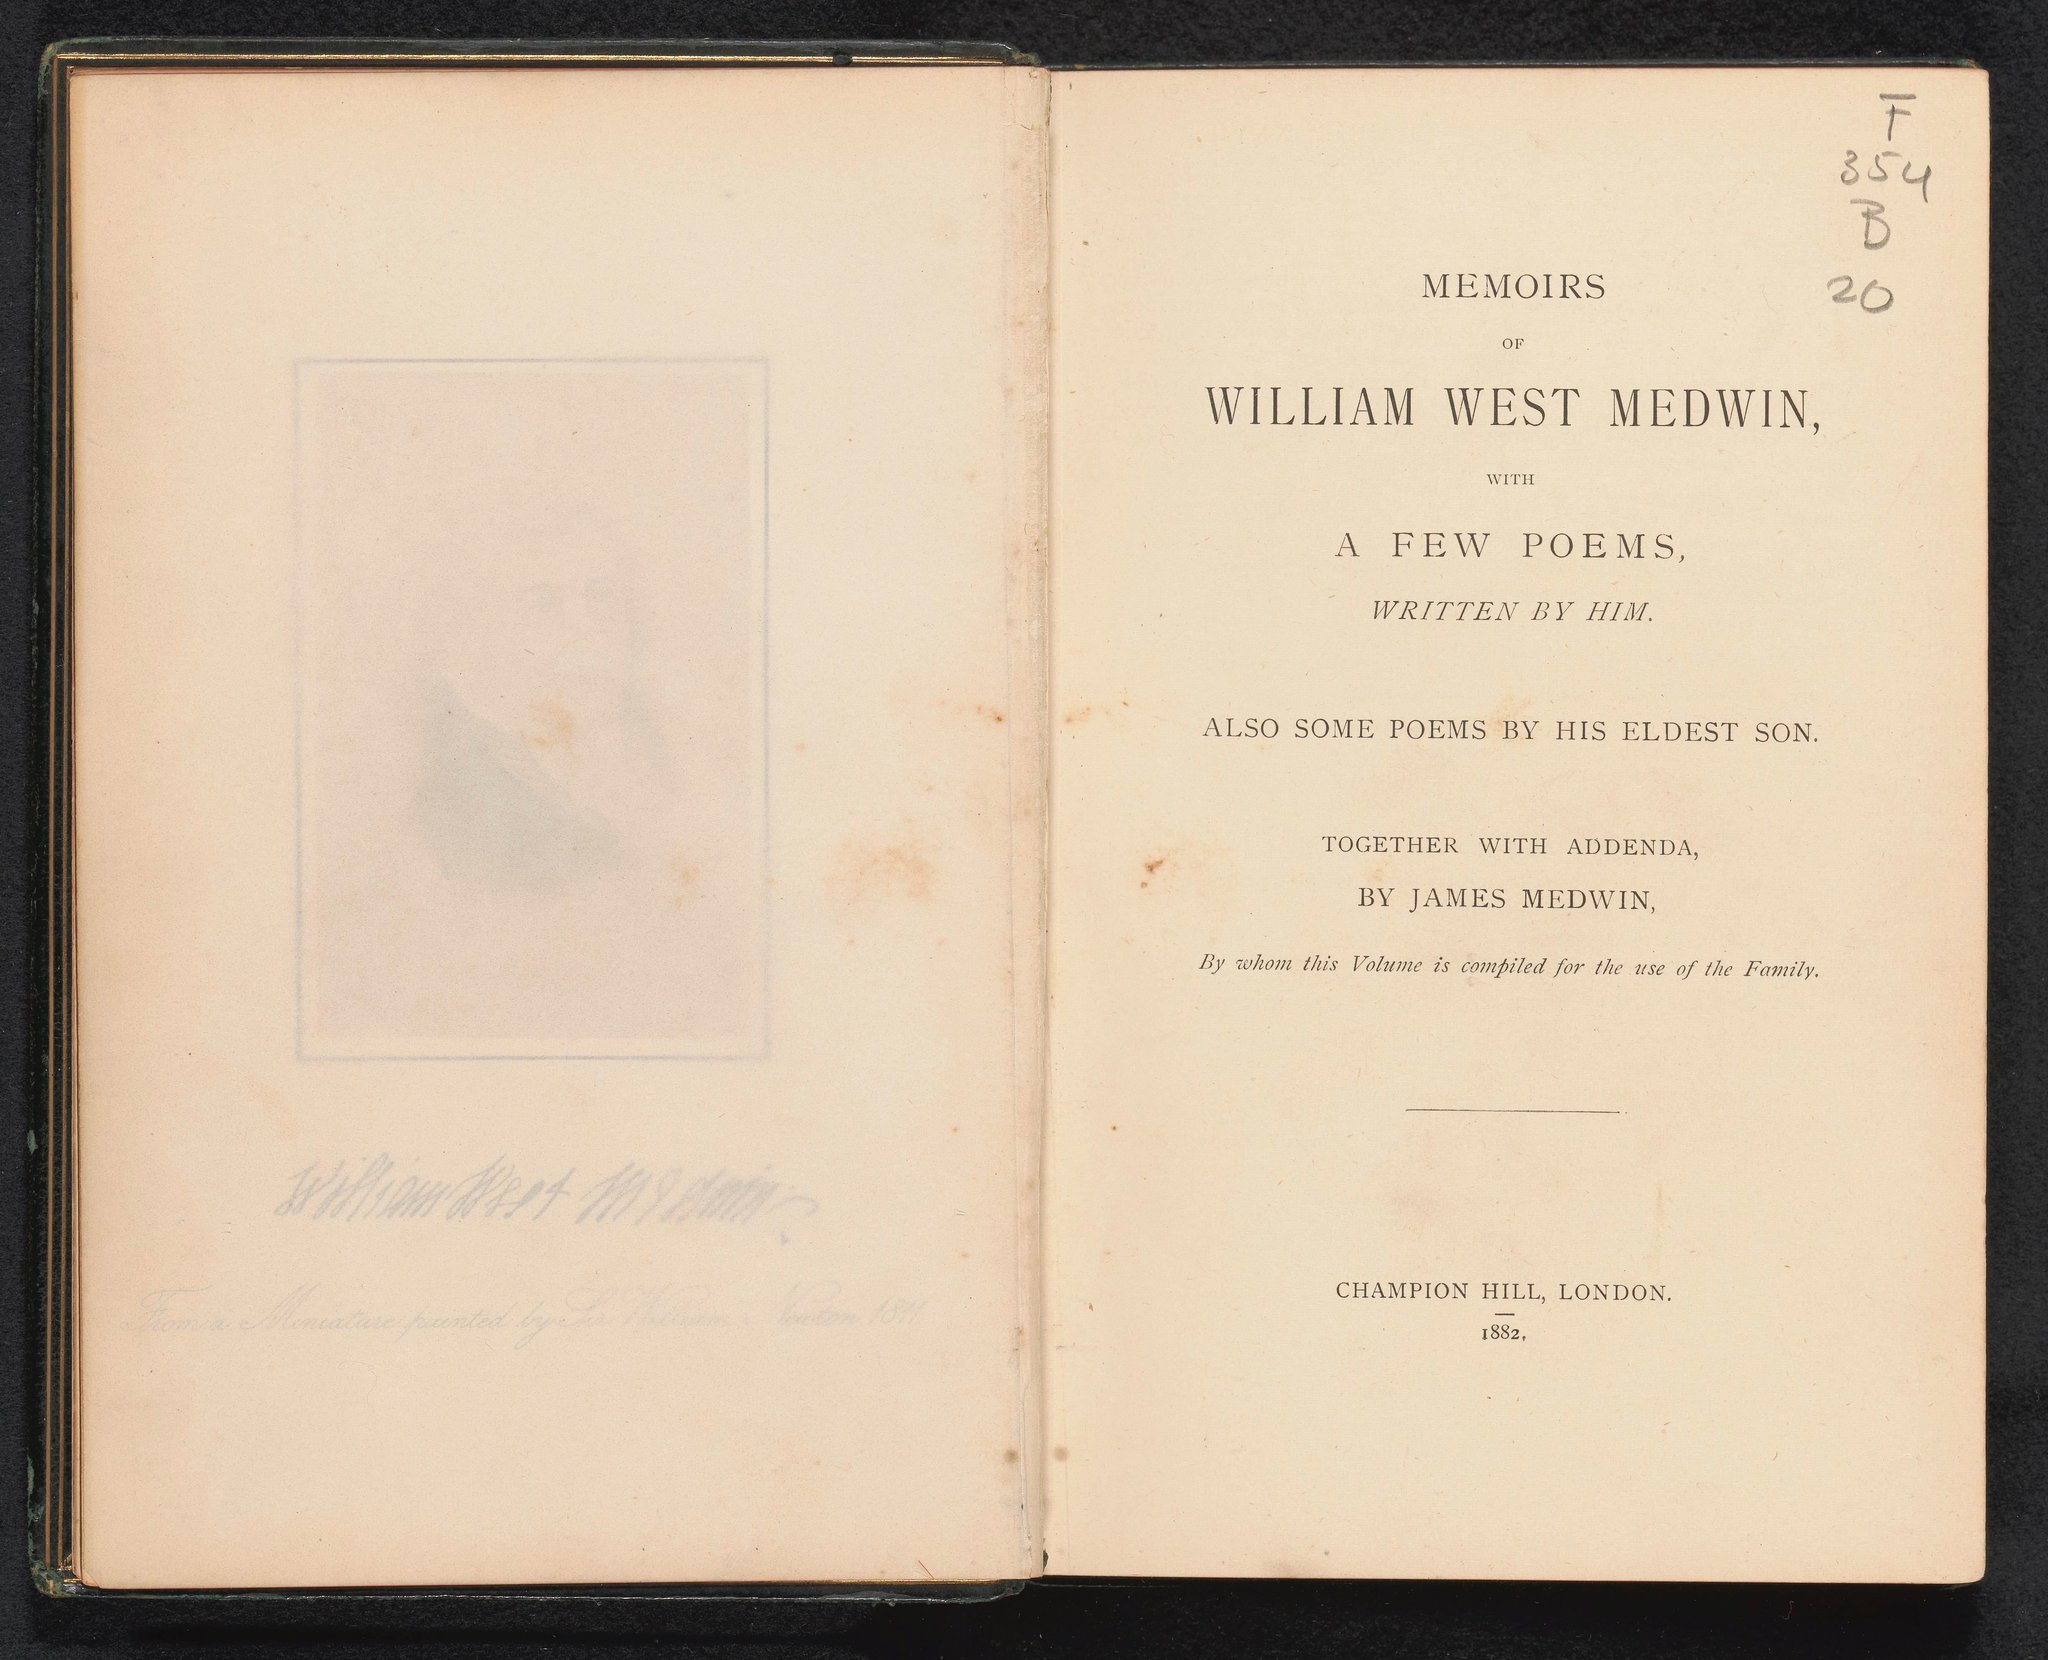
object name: book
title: Memoirs of William West Medwin, with a few poems written by him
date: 1882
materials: cardboard, leather, paper, photographic support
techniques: albumen print, printing, marbled paper